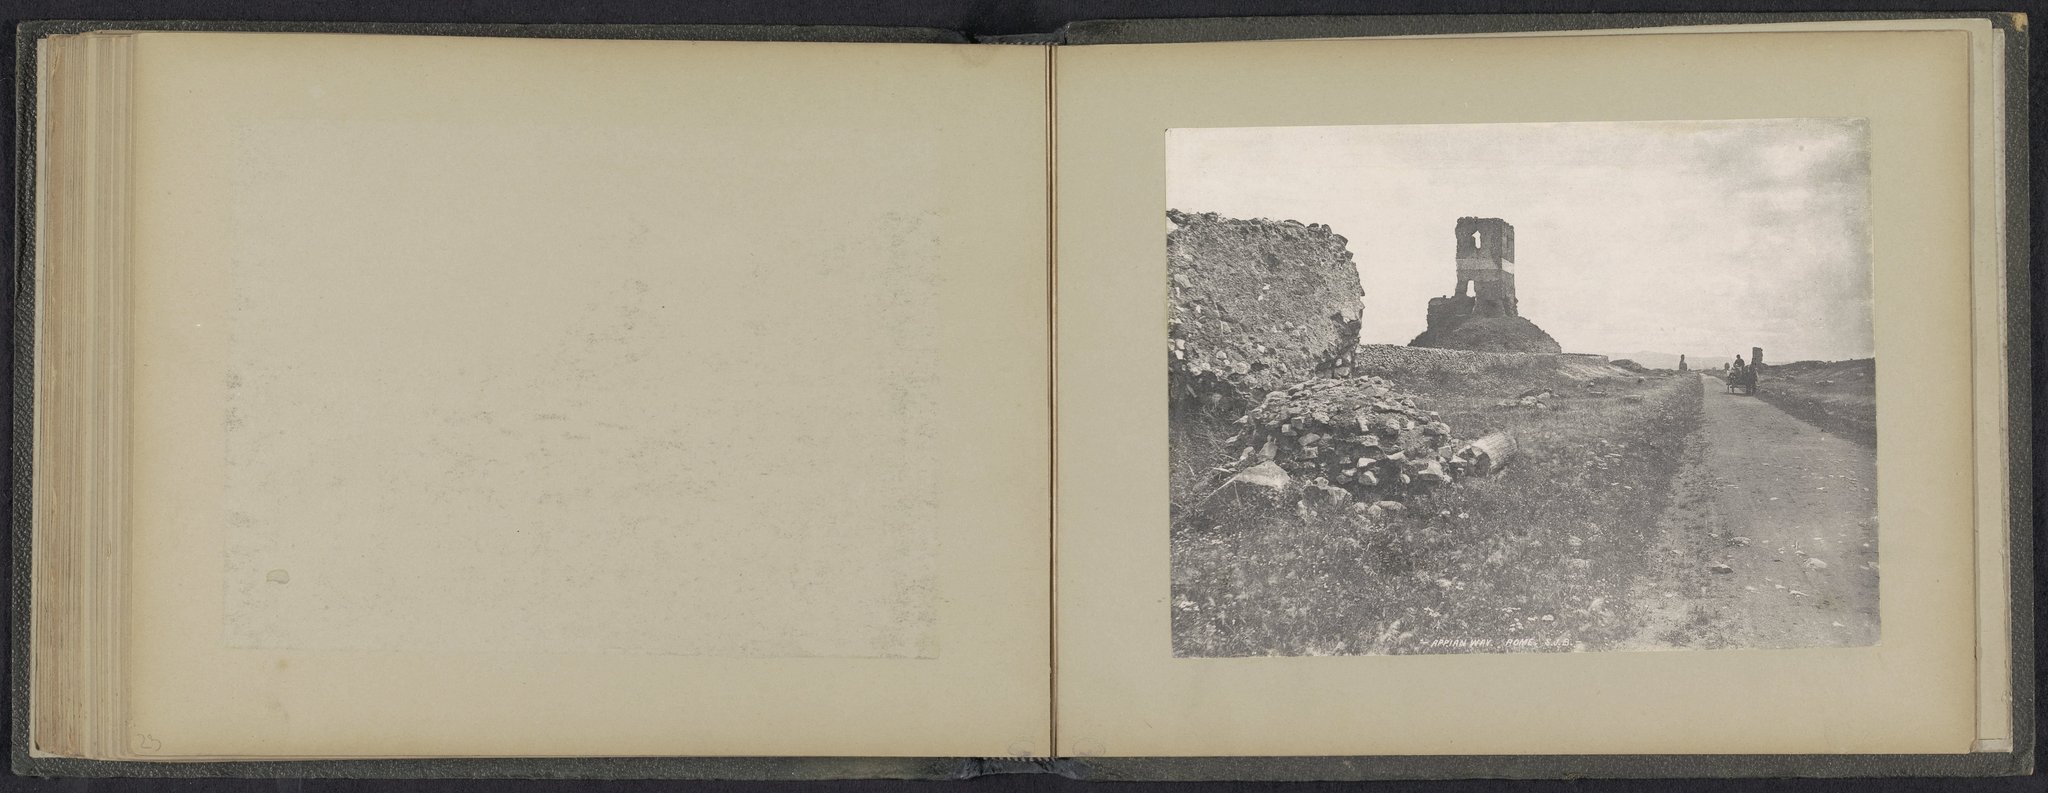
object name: photomechanical print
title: Appian way. Rome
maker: samuel j. beckett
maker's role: fotograaf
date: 1890-1900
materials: paper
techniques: photograph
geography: via appia antica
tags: landscape with ruins, road, path